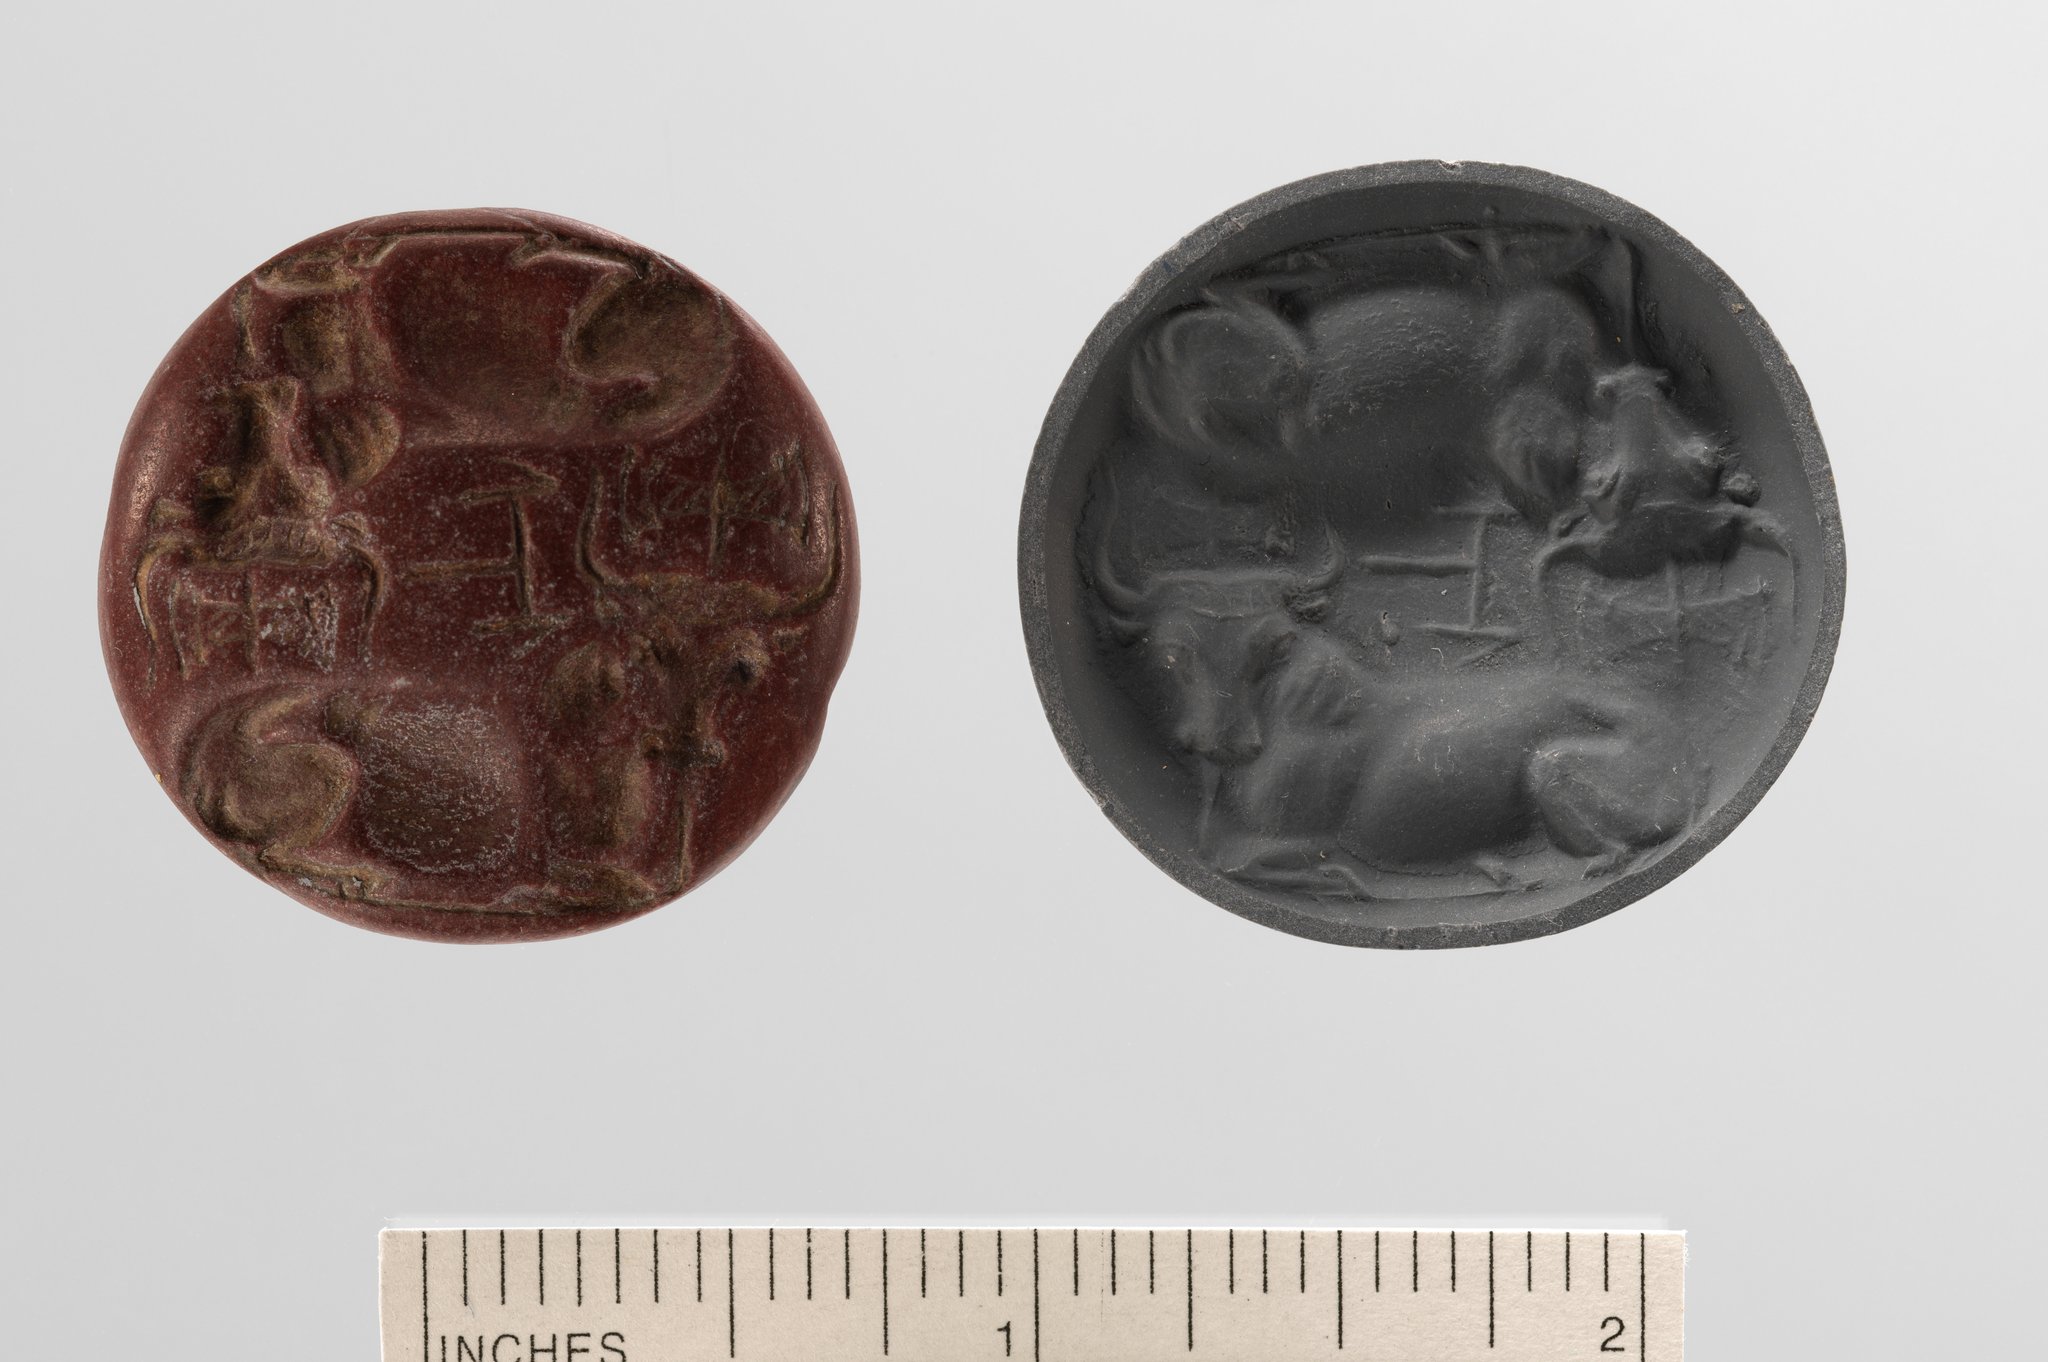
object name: seal, lentoid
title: Jasper Lentoid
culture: minoan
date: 1500-1400 BCE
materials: jasper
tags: bulls